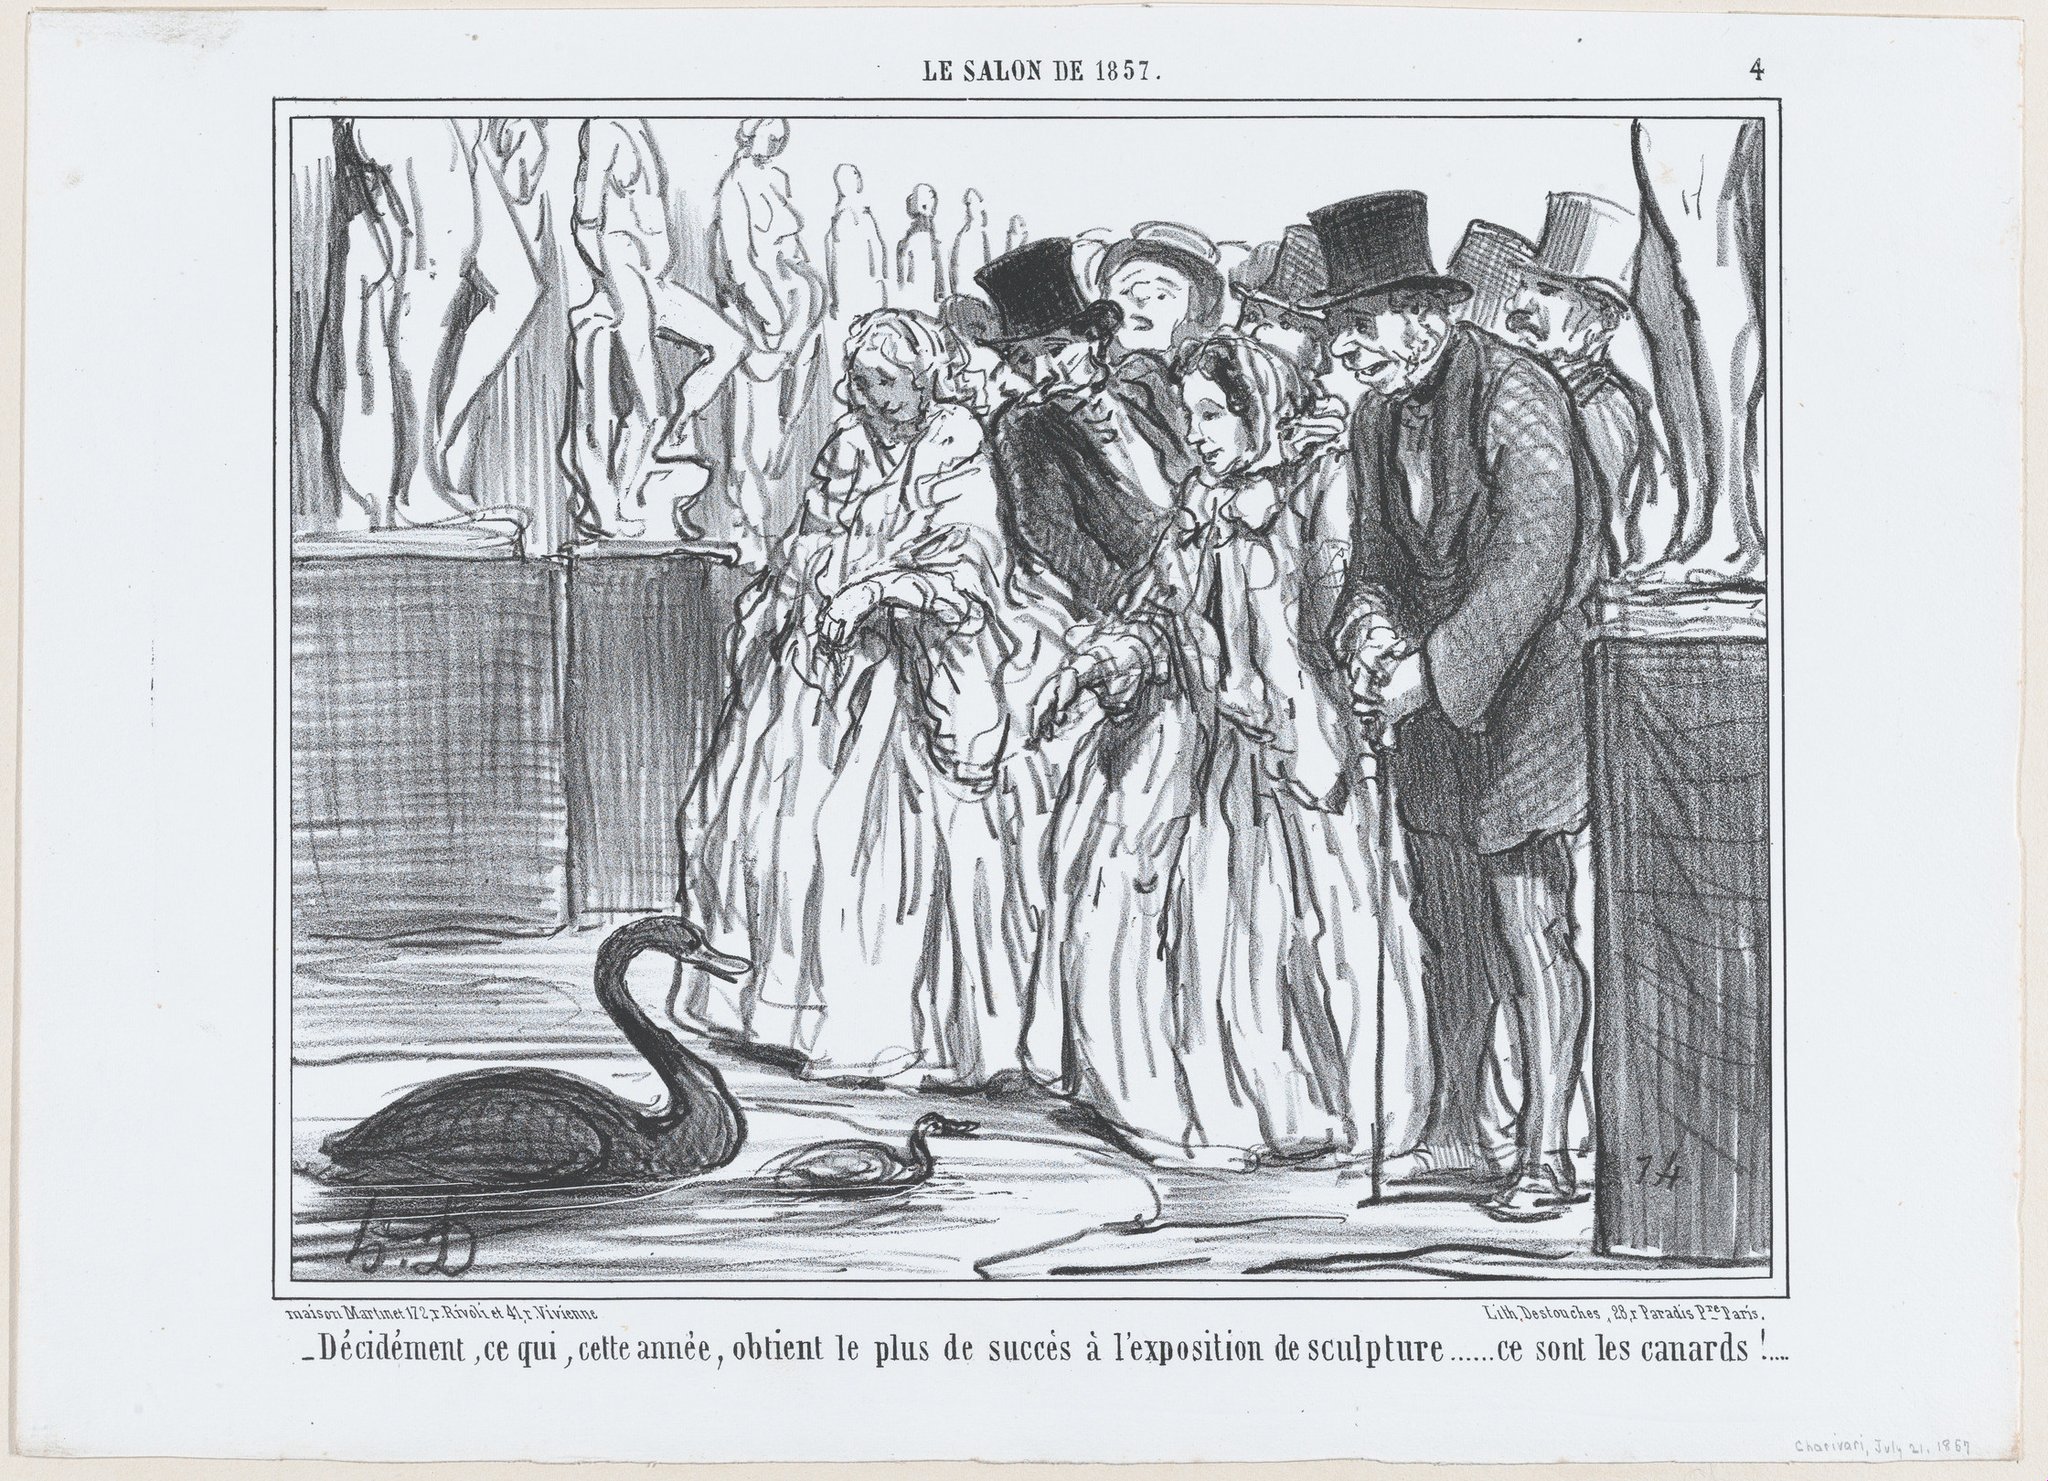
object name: print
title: Décidément, ce qui, cette année, obtient le plus de succès à l'exposition de sculpture..., from Le Salon de 1857, published in "Le Charivari"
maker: honoré daumier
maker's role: artist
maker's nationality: french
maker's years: 1808-1879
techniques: lithograph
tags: men,women,swans